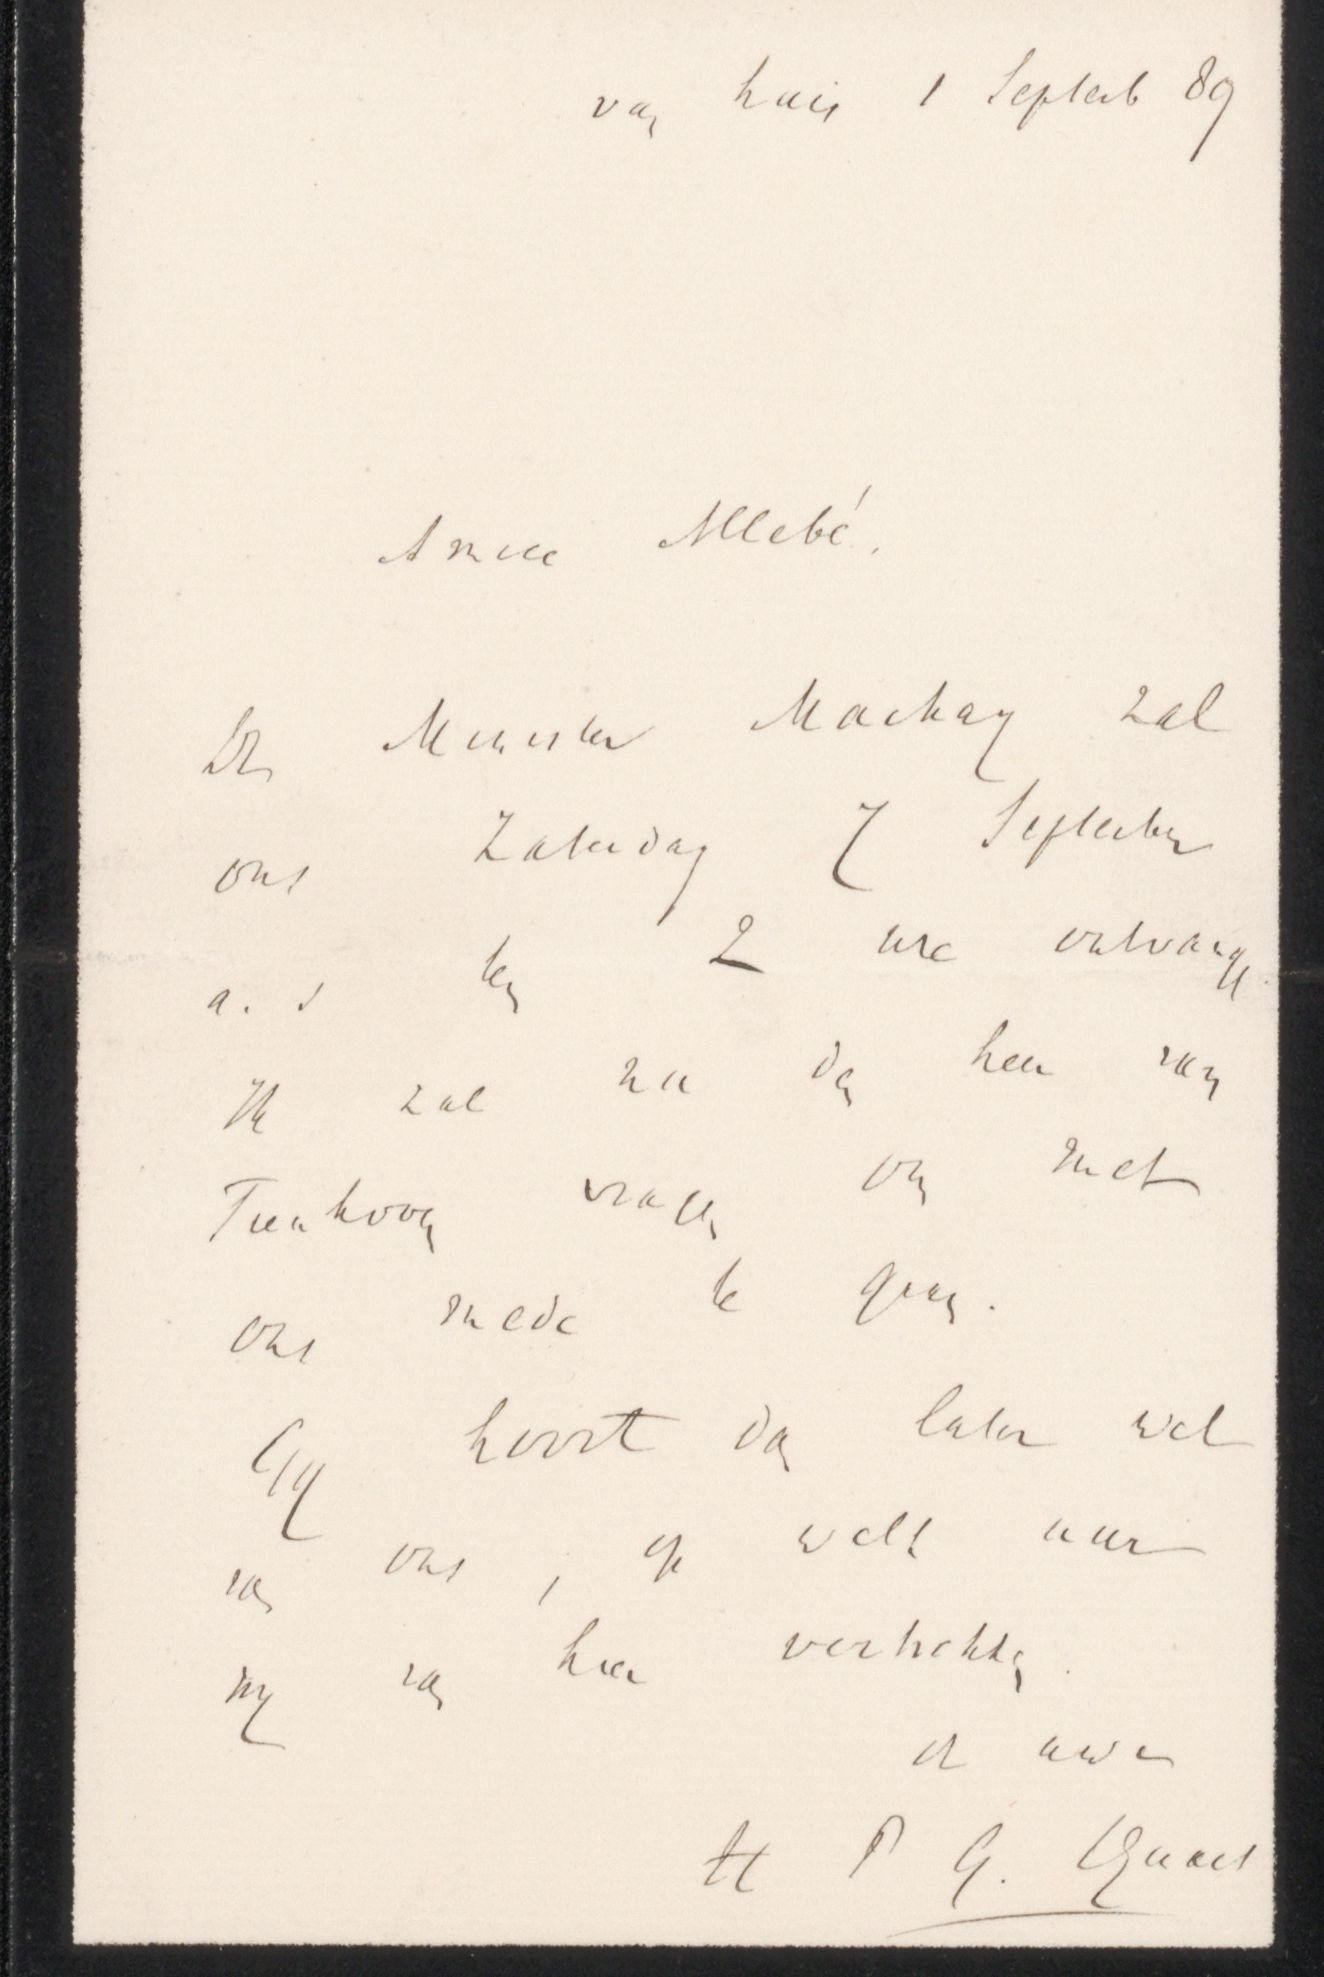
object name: letter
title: Brief aan August Allebé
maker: hendrick peter godfried quack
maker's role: econoom, geschiedschrijver, hoogleraar, jurist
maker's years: 1834-1917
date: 1889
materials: ink, paper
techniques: pen, writing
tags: august allebé, mayor, gijsbert van tienhoven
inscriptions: watermark